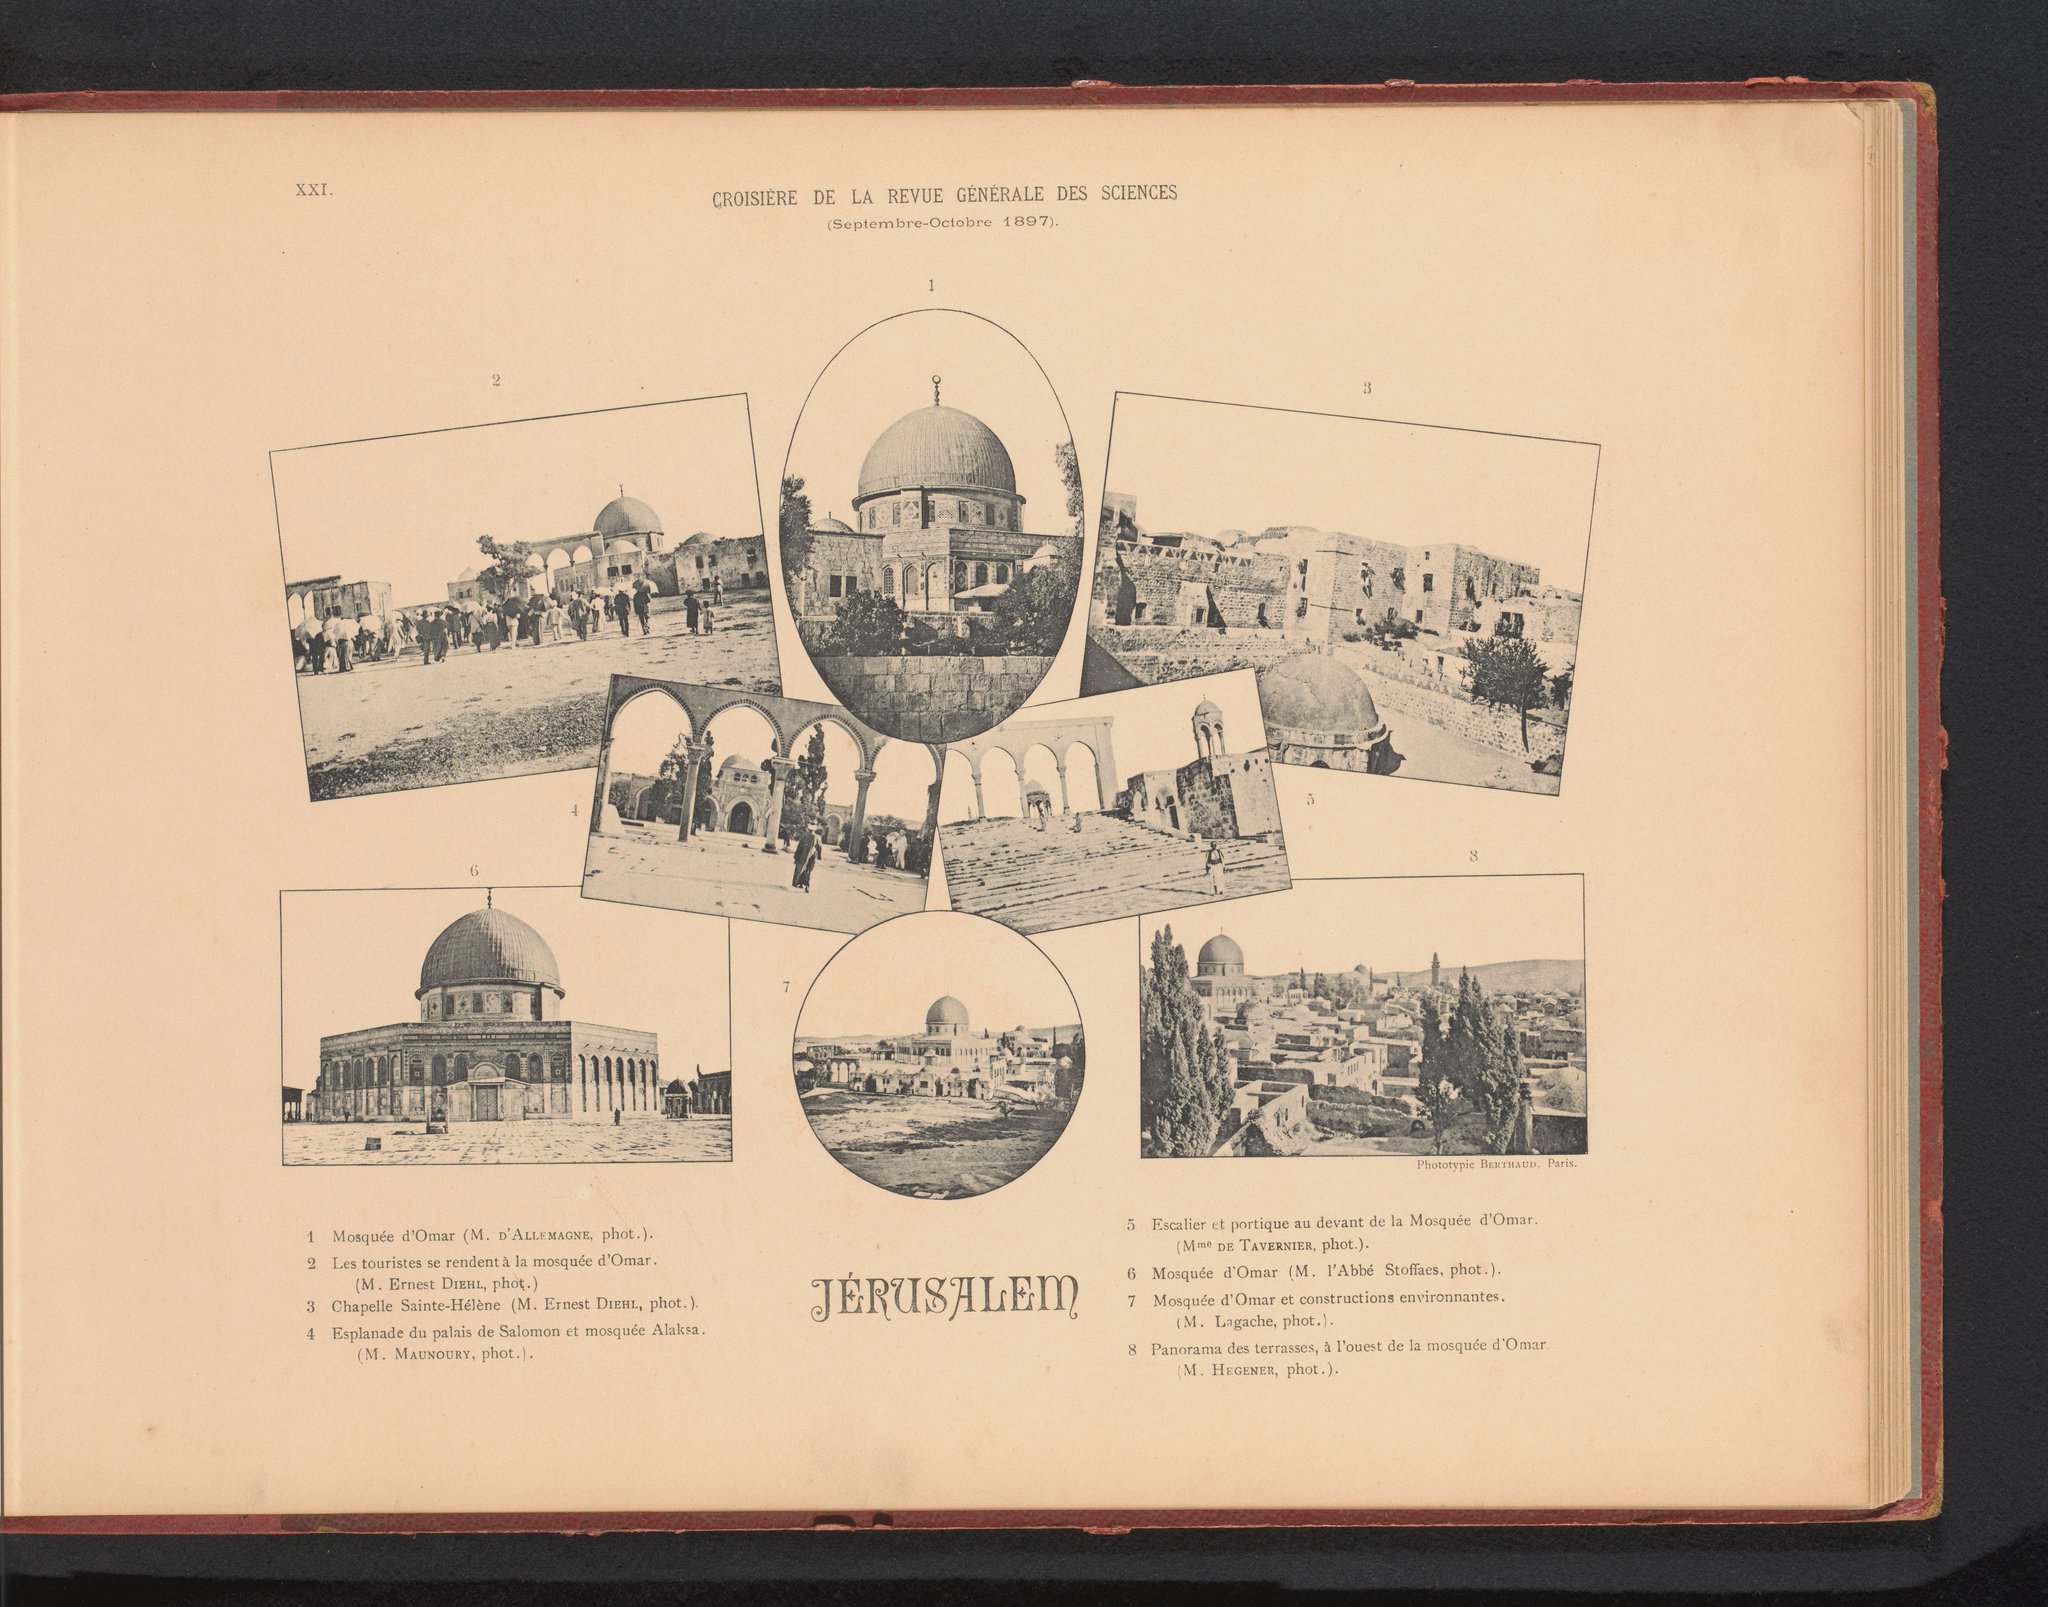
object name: photomechanical print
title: Jérusalem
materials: paper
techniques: photograph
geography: jerusalem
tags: temple, shrine ~ islam, mohammedanism, prospect of city, town panorama, silhouette of city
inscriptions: number: ‘XXI.’, inscription: ‘1 Mosquée d'Omar (M. d'Allemagne, phot.)./ 2 Les touristes se rendent à la mosquée d'Omar./ (M. Ernest Diehl, phot.)./ 3 Chapelle Sainte-Hélène (M. Ernest Diehl, phot.)./ 4 Esplanade du palais de Salomon et mosquée Alaksa./ (M. Maunoury, phot.)./ 5 Escalier et portique au devant de la Mosquée d'Omar./ (Mme de Tavernier, phot.)./ 6 Mosquée d'Omar (M. l'Abbé Stoffaes, phot.)./ 7 Mosquée d'Omar et constructions environnantes./ (M. Lagache, phot.)./ 8 Panorama des terrasses, à l'ouest de la mosquée d'Omar./ (M. Hegener, phot.).’